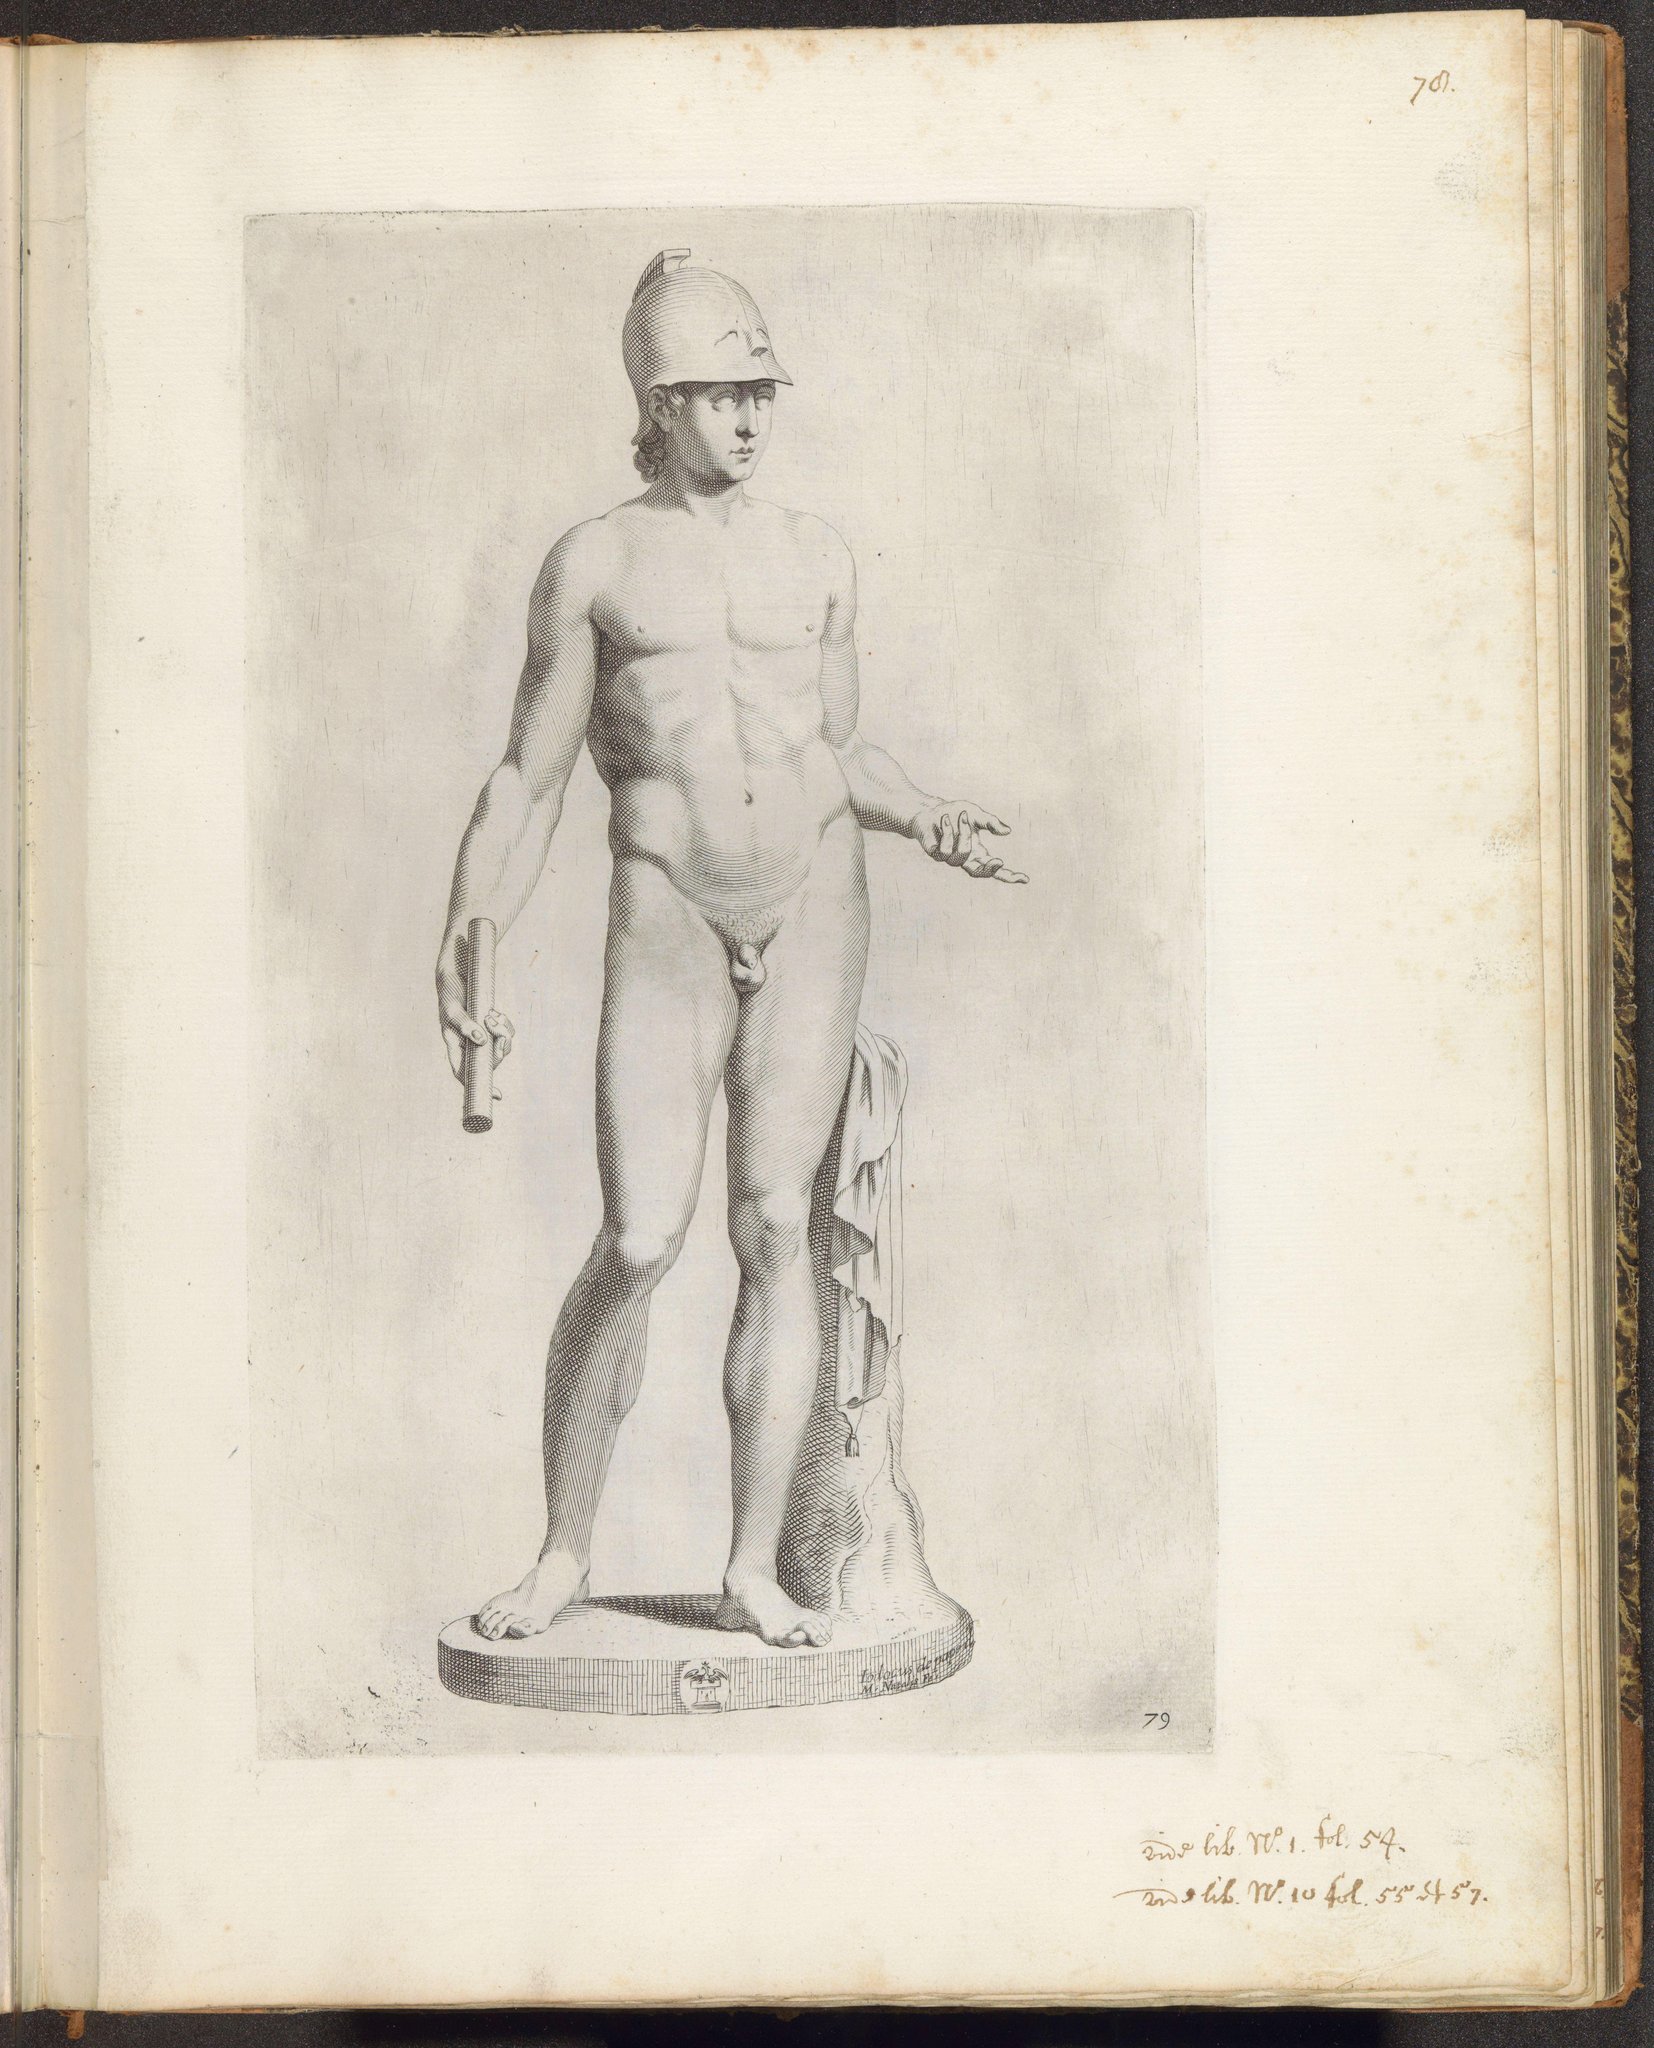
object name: album leaf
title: Galleria Giustiniana del Marchese Vincenzo Giustiniani I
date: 1636-1647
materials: paper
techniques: engraving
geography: rome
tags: (story of) mercury (hermes), piece of sculpture, reproduction of a piece of sculpture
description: Standbeeld van de naakte Mercurius met een helm op het hoofd, een stok in zijn rechterhand, staand naast een boomstam. Op de basis het wapenschild van Vincenzo Giustiniani. Prent maakt deel uit van een album met een serie prenten naar de sculpturen in de verzameling in de Galleria Giustiniani te Rome.